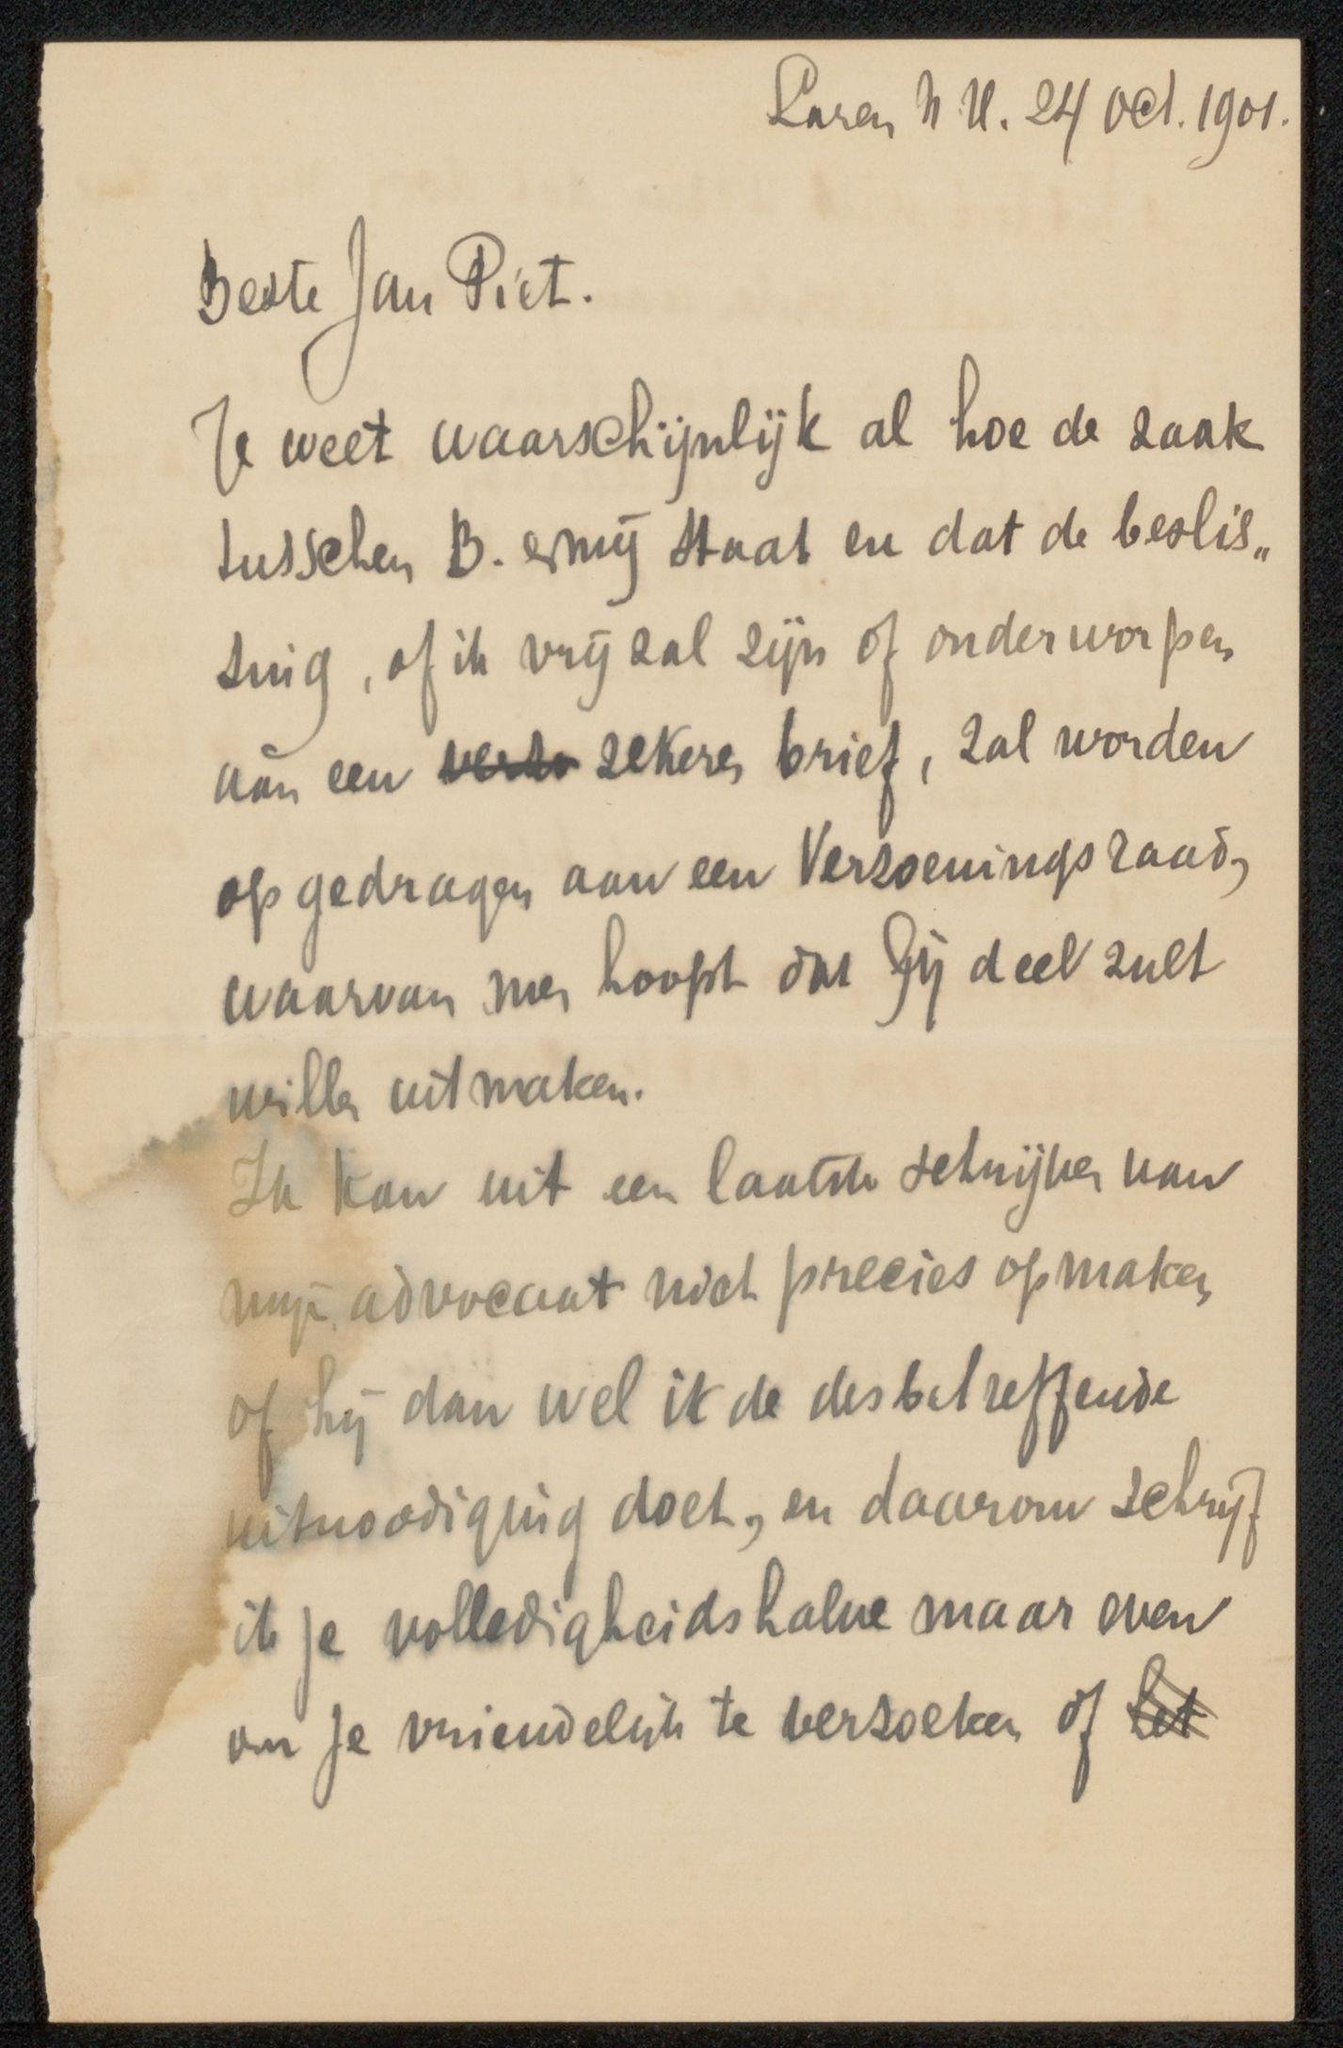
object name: letter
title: Brief aan Jan Veth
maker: antoon derkinderen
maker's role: draughtsman, painter, print maker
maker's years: 1859-1925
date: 1901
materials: ink, paper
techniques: pen, writing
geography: laren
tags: jan veth, hendrik petrus berlage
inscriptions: collector's mark: ‘RPK’